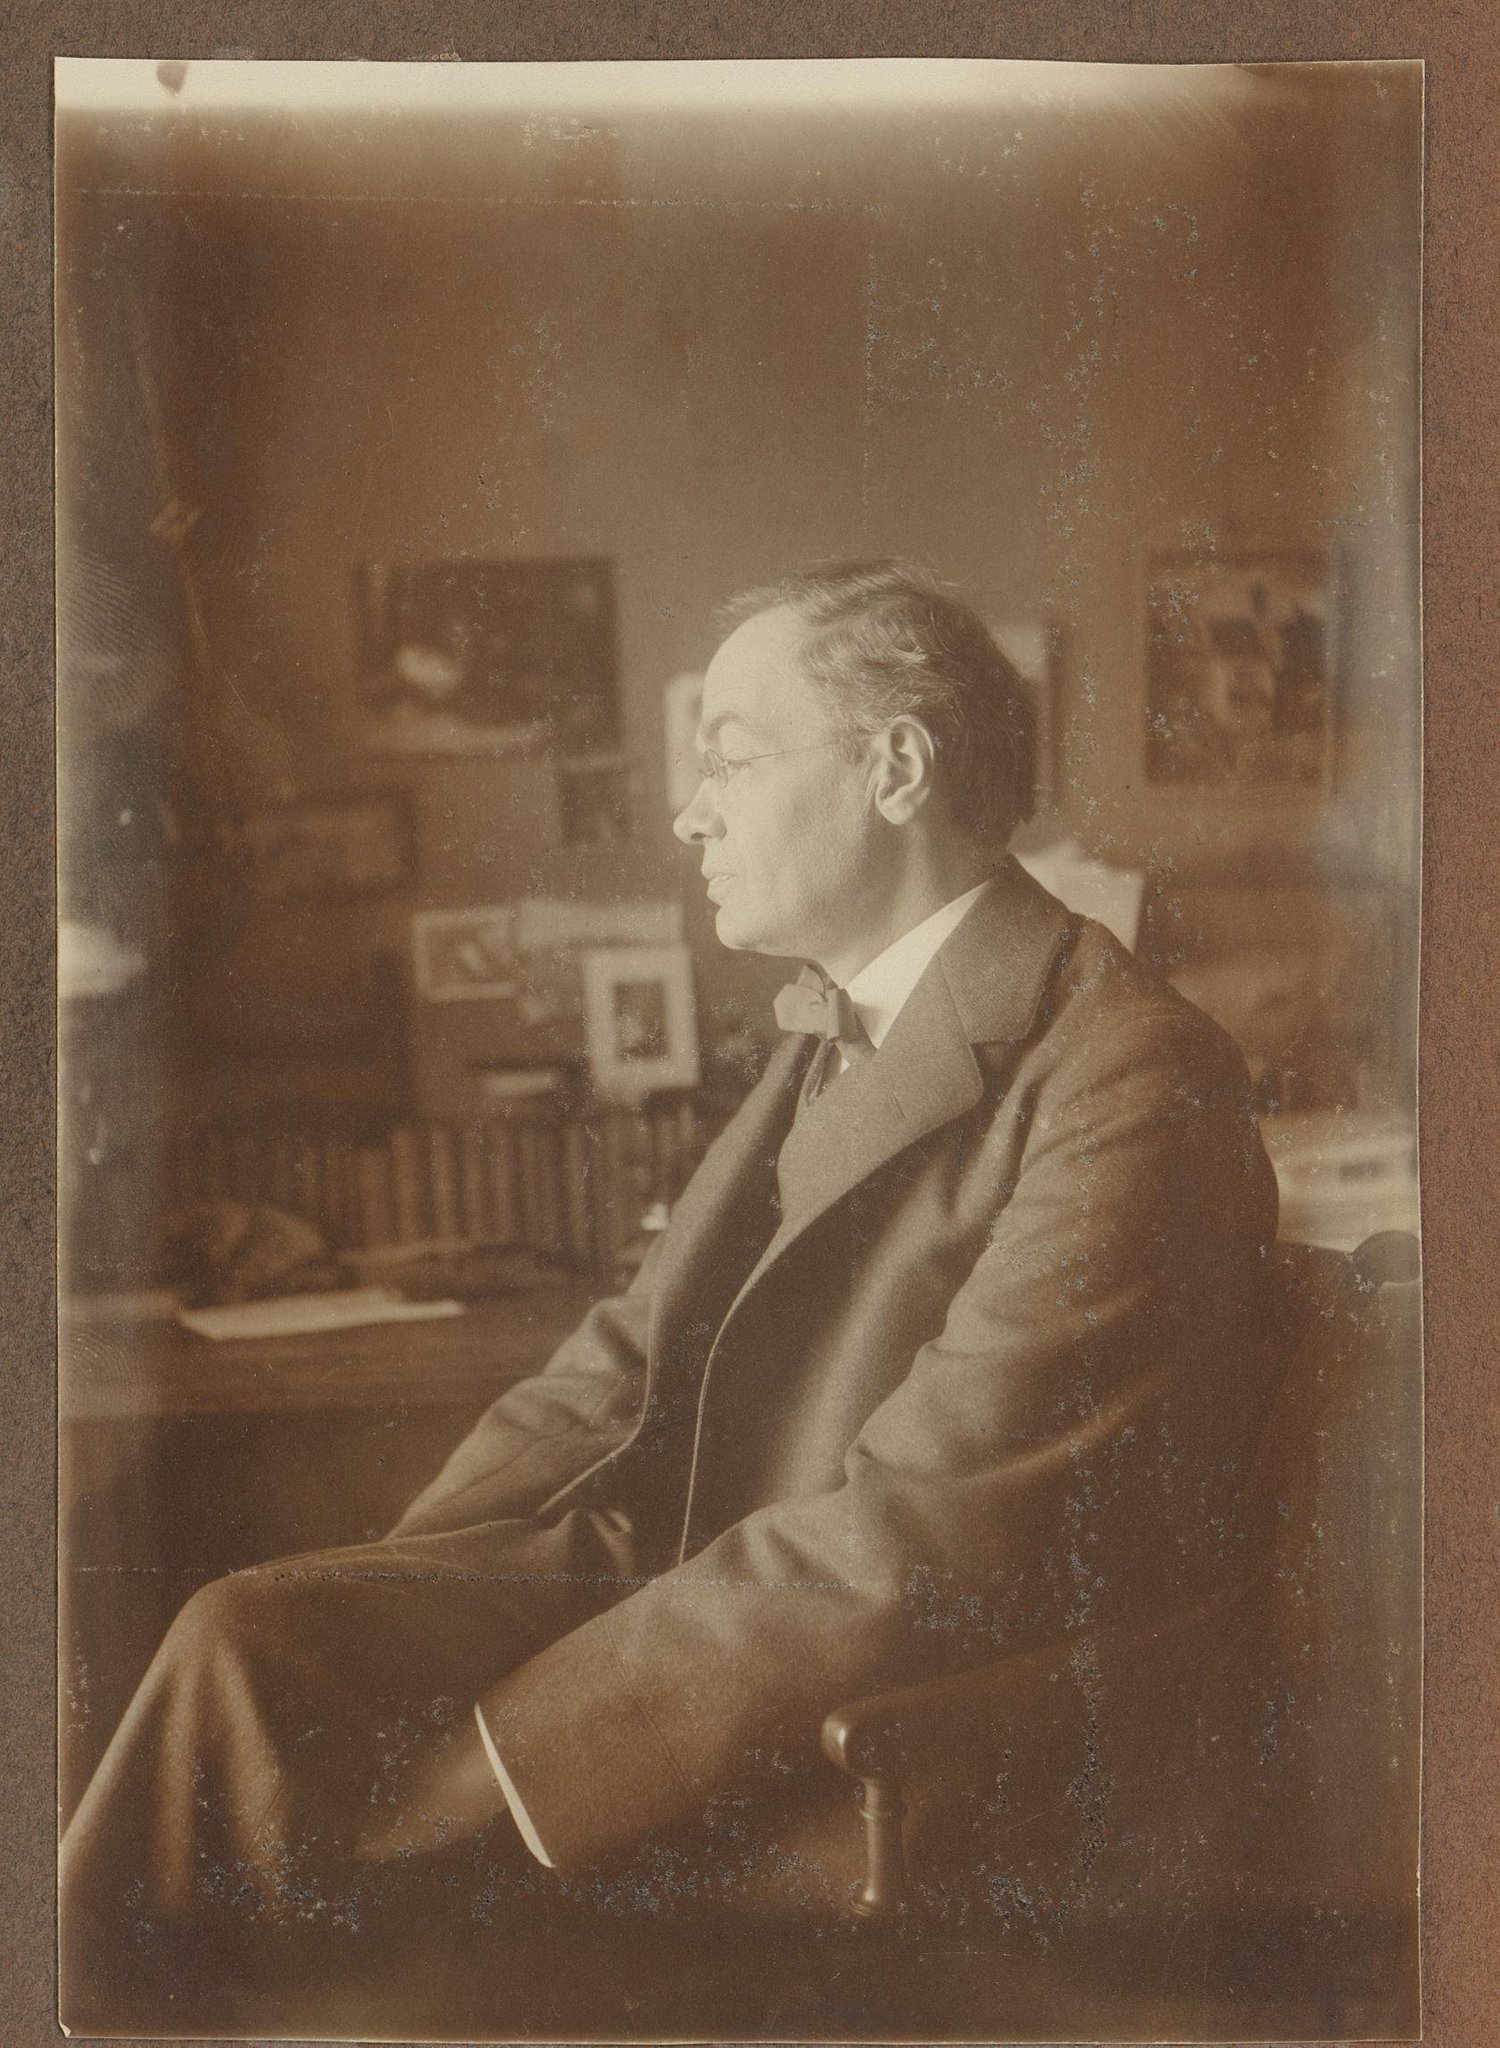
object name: photograph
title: Alphons Diepenbrock zittend in interieur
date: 1912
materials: photographic support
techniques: photography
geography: netherlands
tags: amsterdam, alphons diepenbrock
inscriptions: date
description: Foto op bruin albumblad 7 van familiealbum van Alphons Diepenbrock.